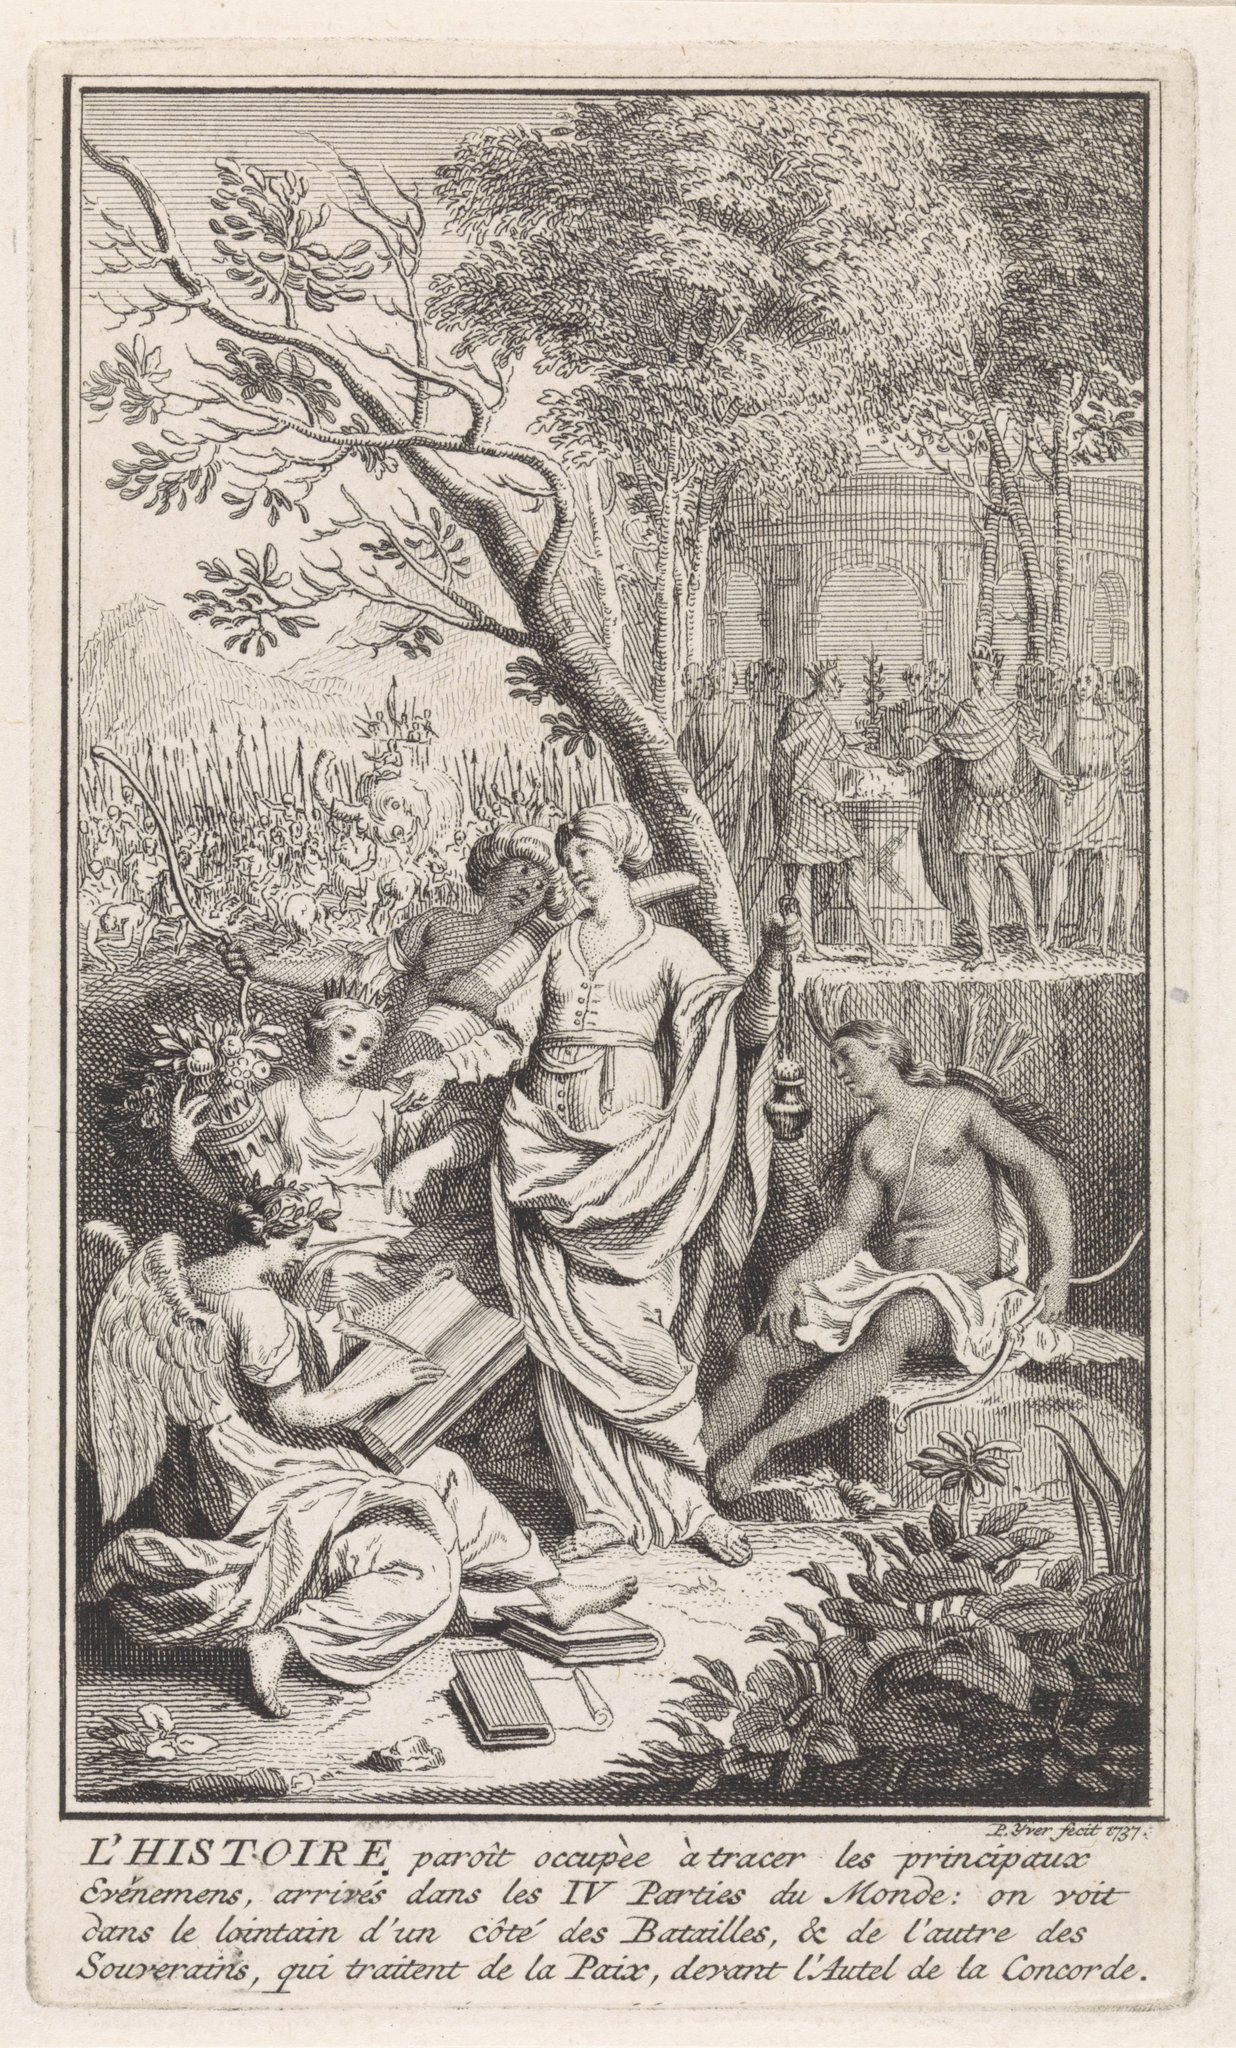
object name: print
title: Geschiedenis en de vier werelddelen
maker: pieter yver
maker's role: print maker, publisher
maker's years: 1712-1787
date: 1737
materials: paper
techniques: engraving, etching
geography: amsterdam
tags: europe represented allegorically; 'europa' (ripa), asia represented allegorically; 'asia' (ripa), africa represented allegorically; 'africa' (ripa), america represented allegorically; 'america' (ripa), 'historia'; 'historia' (ripa)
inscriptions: collector's mark: Lugt 240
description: Geschiedenis, met vleugels en lauwerkrans op het hoofd, schrijft in haar boek. Bij haar staan de personificaties van de vier werelddelen. Van links naar rechts: Europa met een hoorn des overvloeds en kroon op het hoofd, Afrika met tulband op het hoofd, Azië met een wierookvat en Amerika met verentooi en boog. Op de achtergrond het wereldtoneel met links een slagveld en rechts de vrede, die tussen twee heersers wordt gesloten. Onderaan in de marge een vierregelige tekst in het Frans.